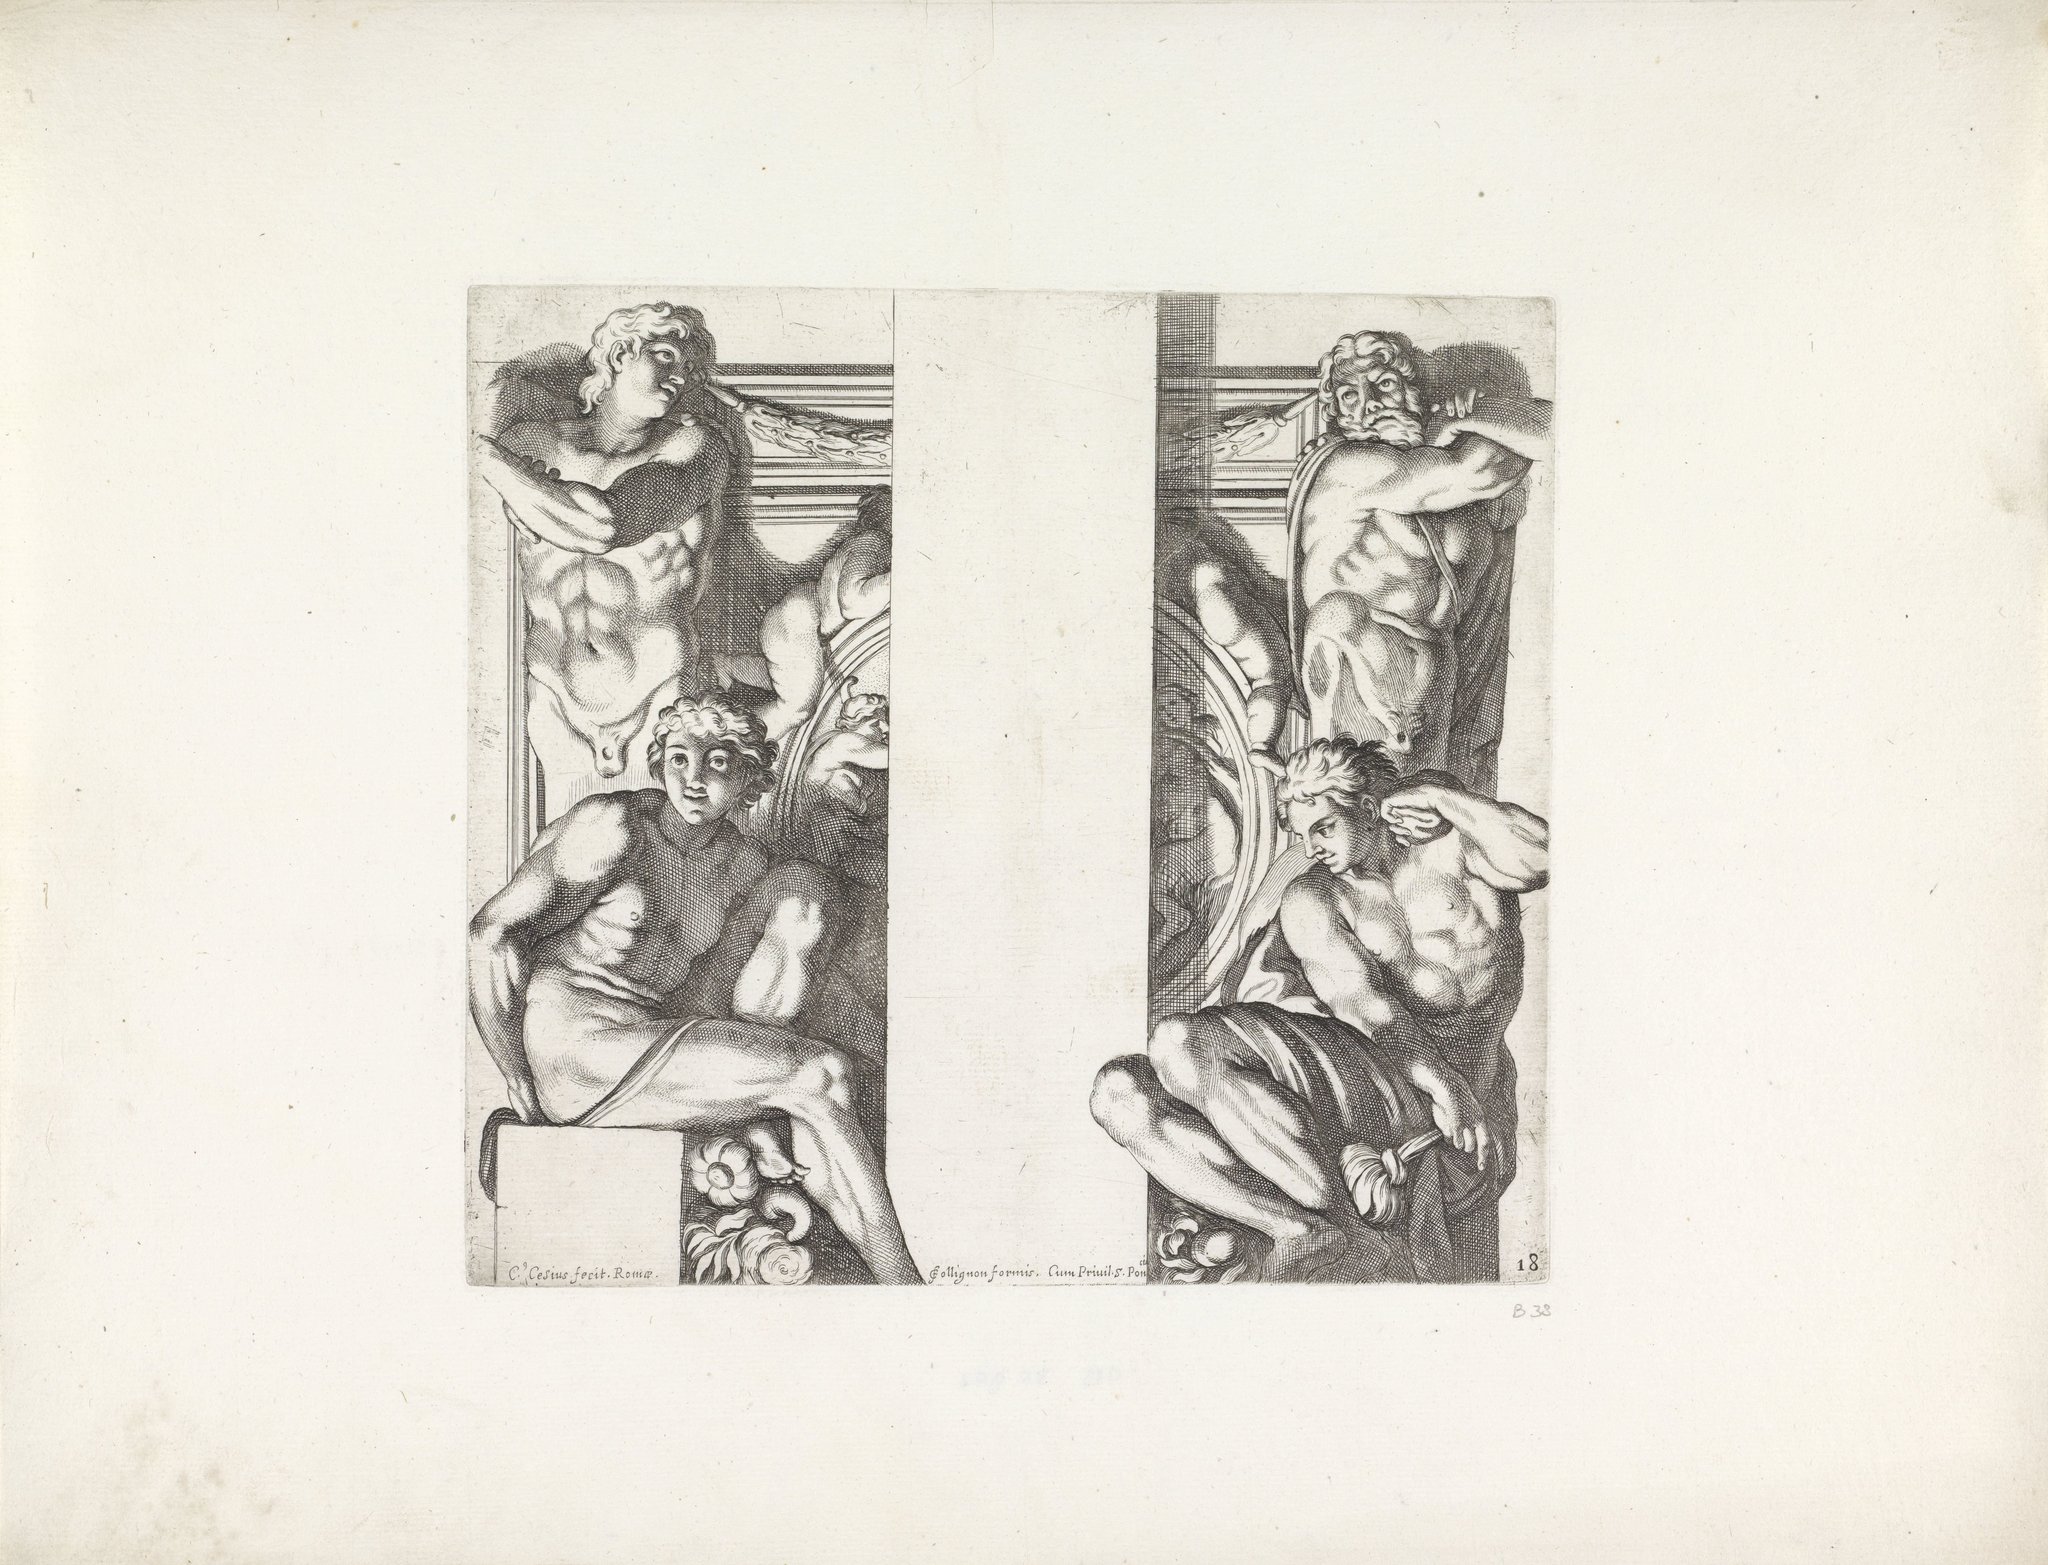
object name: print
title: Termen en naakte mannelijke figuren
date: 1656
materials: paper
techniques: etching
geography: rome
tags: the (nude) human figure; 'corpo humano' (ripa), cupids: 'amores', 'amoretti', 'putti'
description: Prent uit een reeks prenten met nummers van 1 tot en met 29 (sommige prenten hebben hetzelfde nummer), plus titelprent en opdracht, naar schilderingen in Palazzo Farnese te Rome.